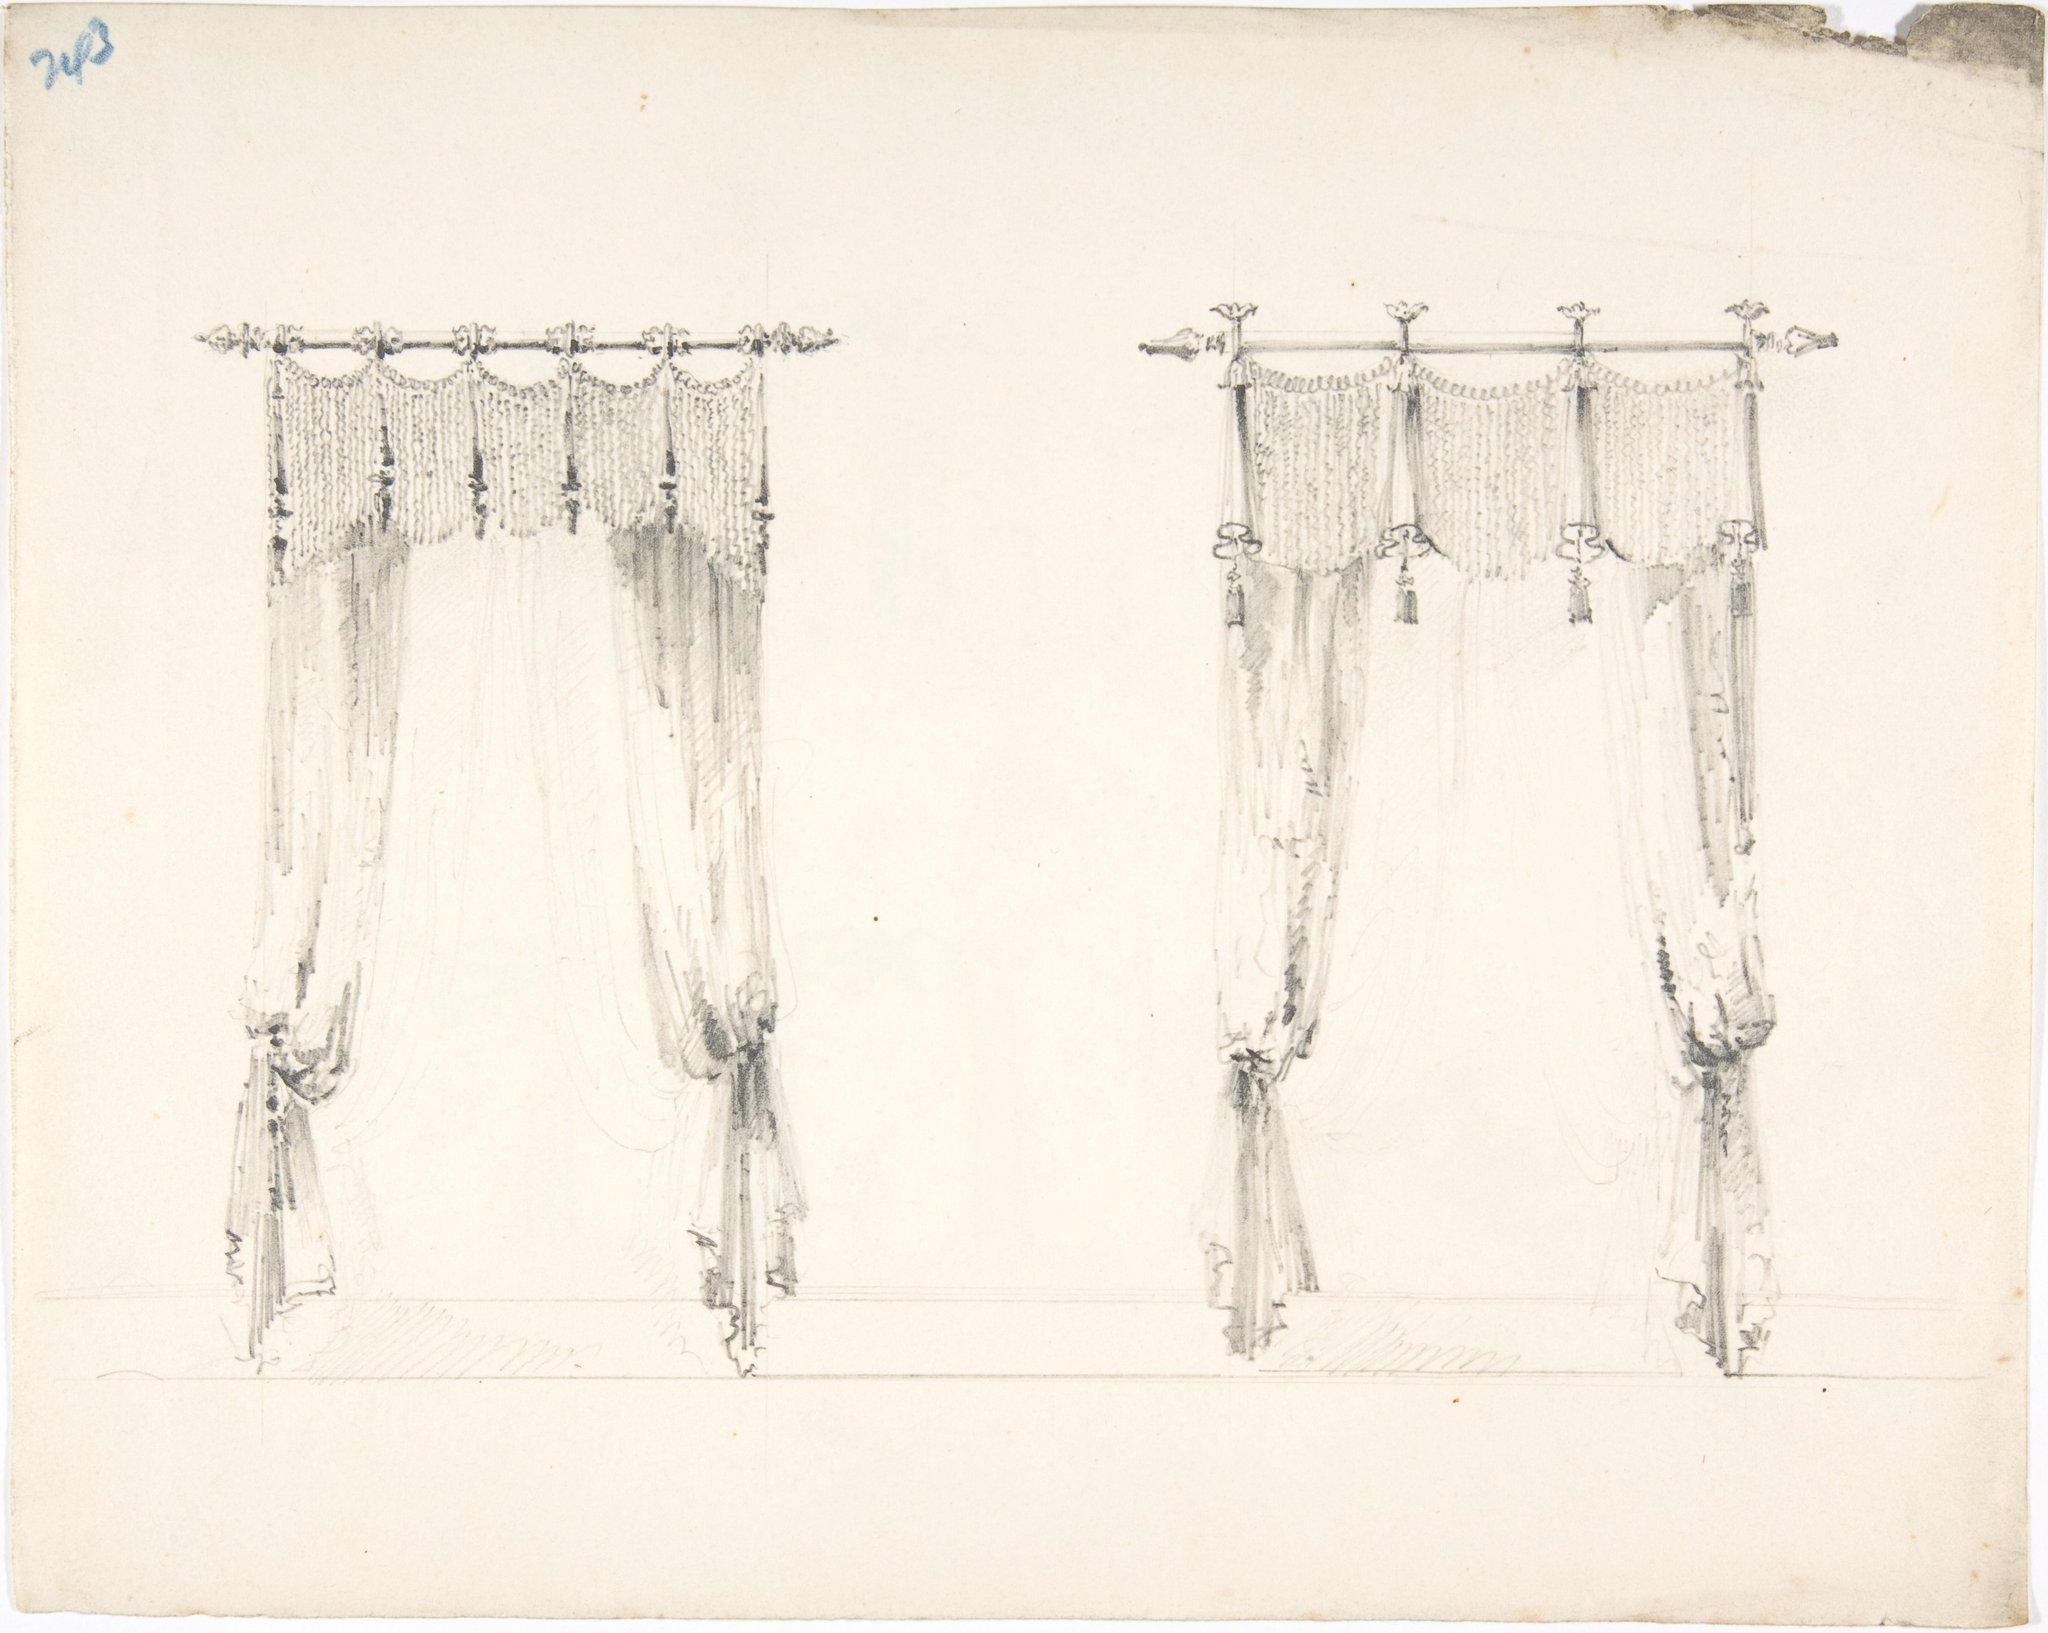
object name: drawing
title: Design for Two Fringed Curtains Handing from Rods (Verso: Sketches)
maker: anonymous, british, 19th century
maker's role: artist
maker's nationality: british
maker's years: 1800-1900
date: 1801-1833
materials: graphite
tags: windows,curtains